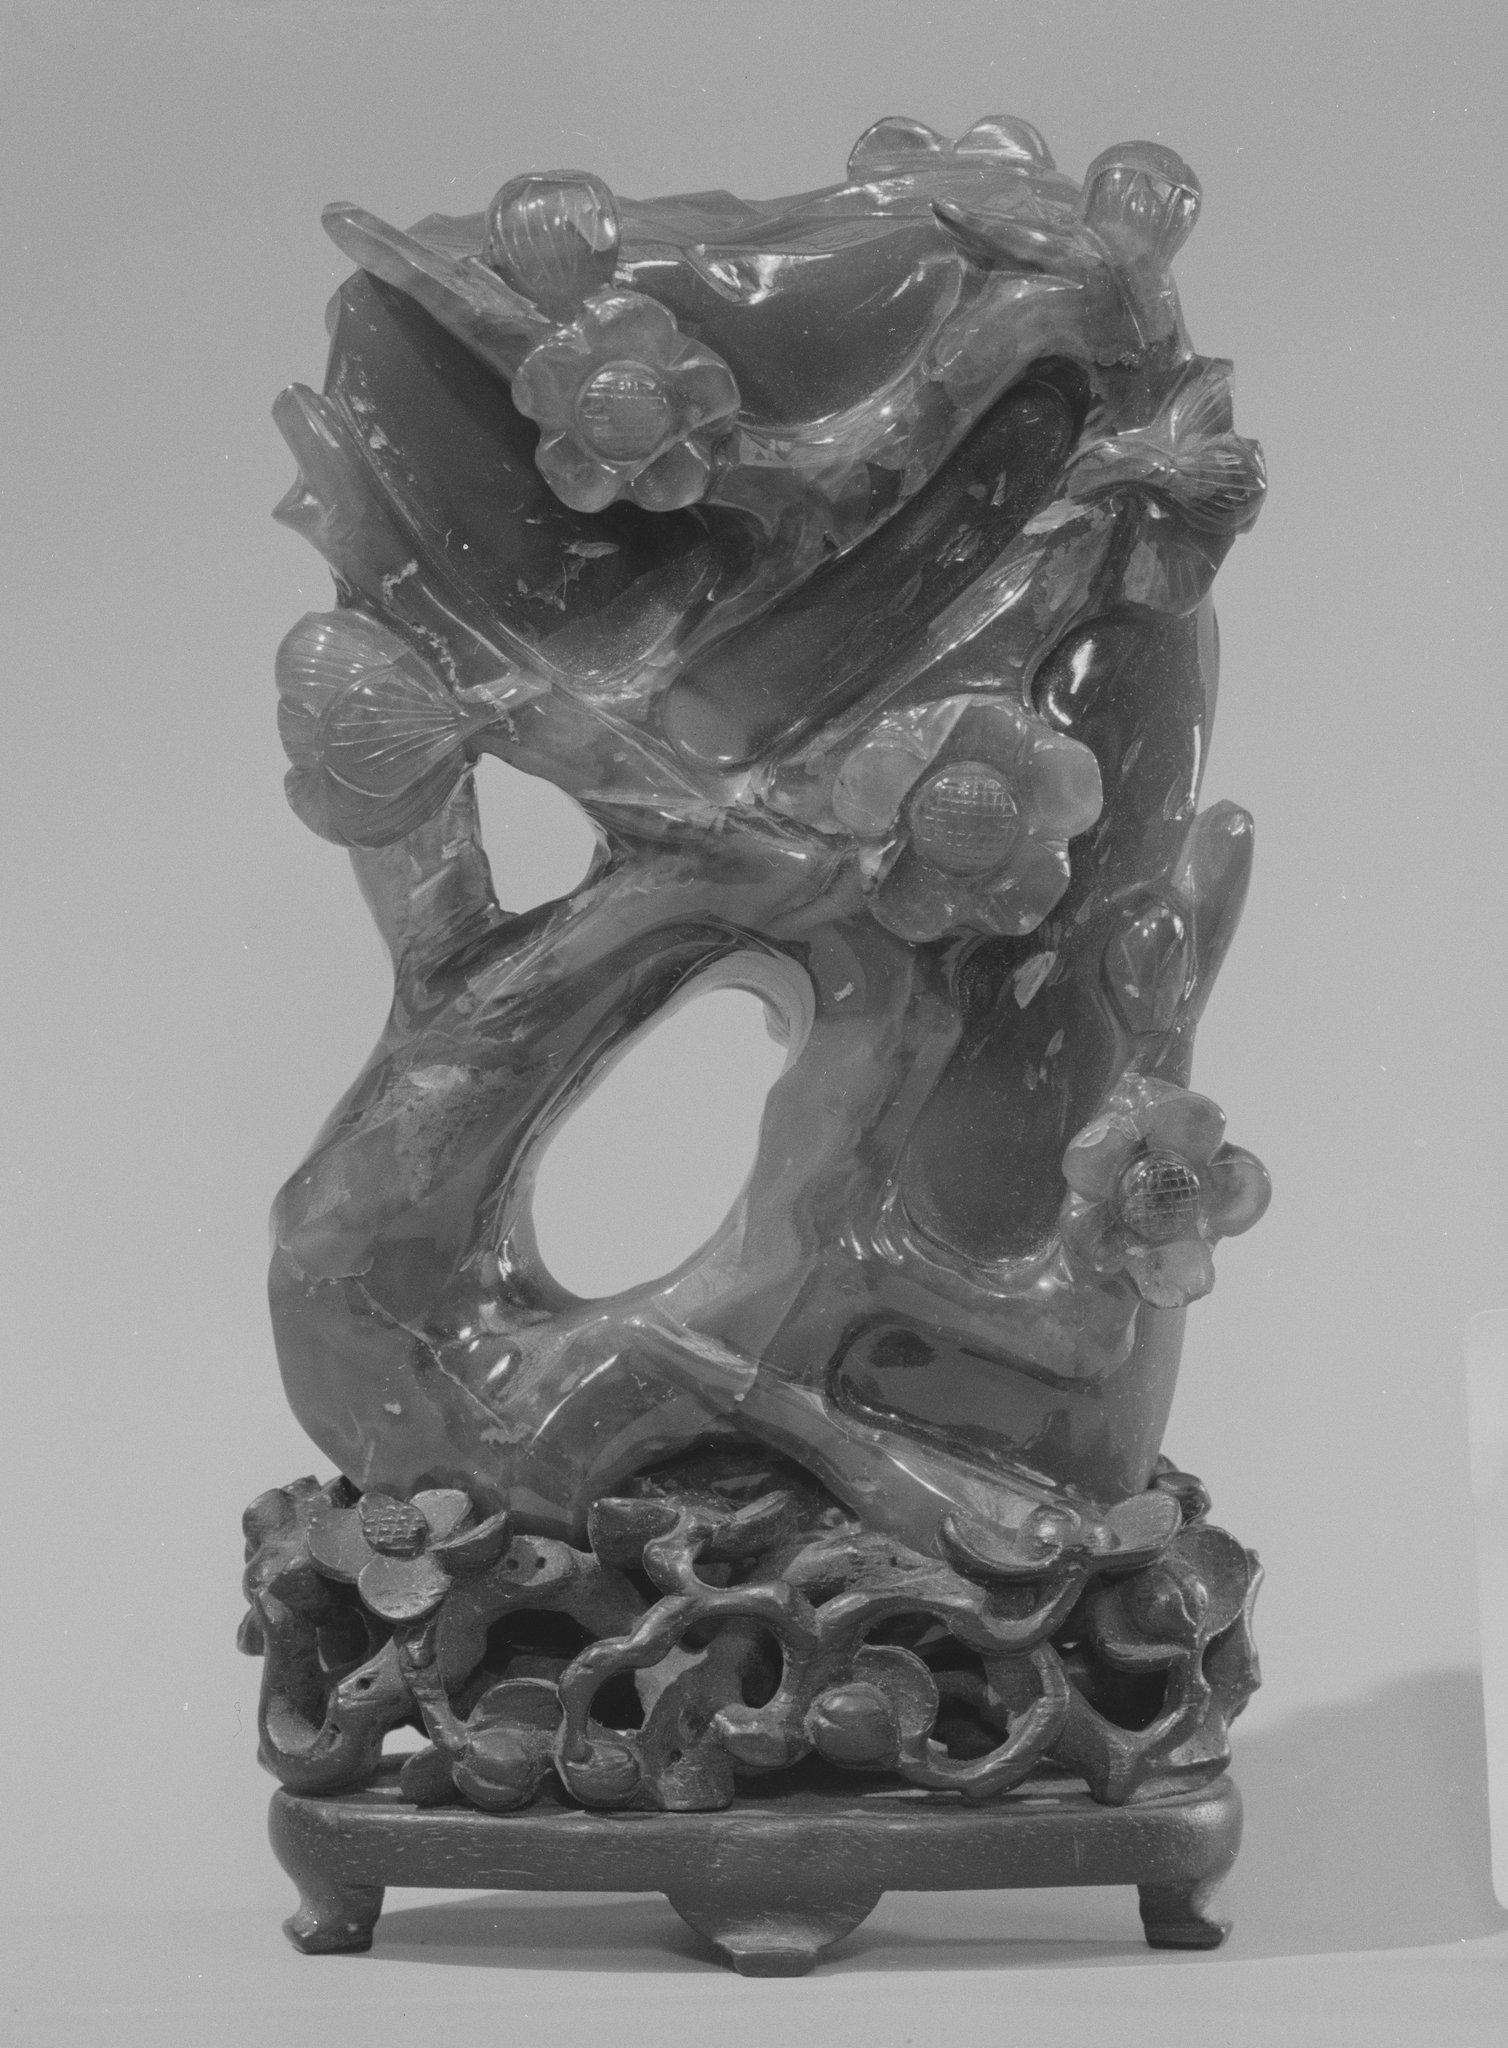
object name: vase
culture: chinese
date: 1801-1900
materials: gemstone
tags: flowers